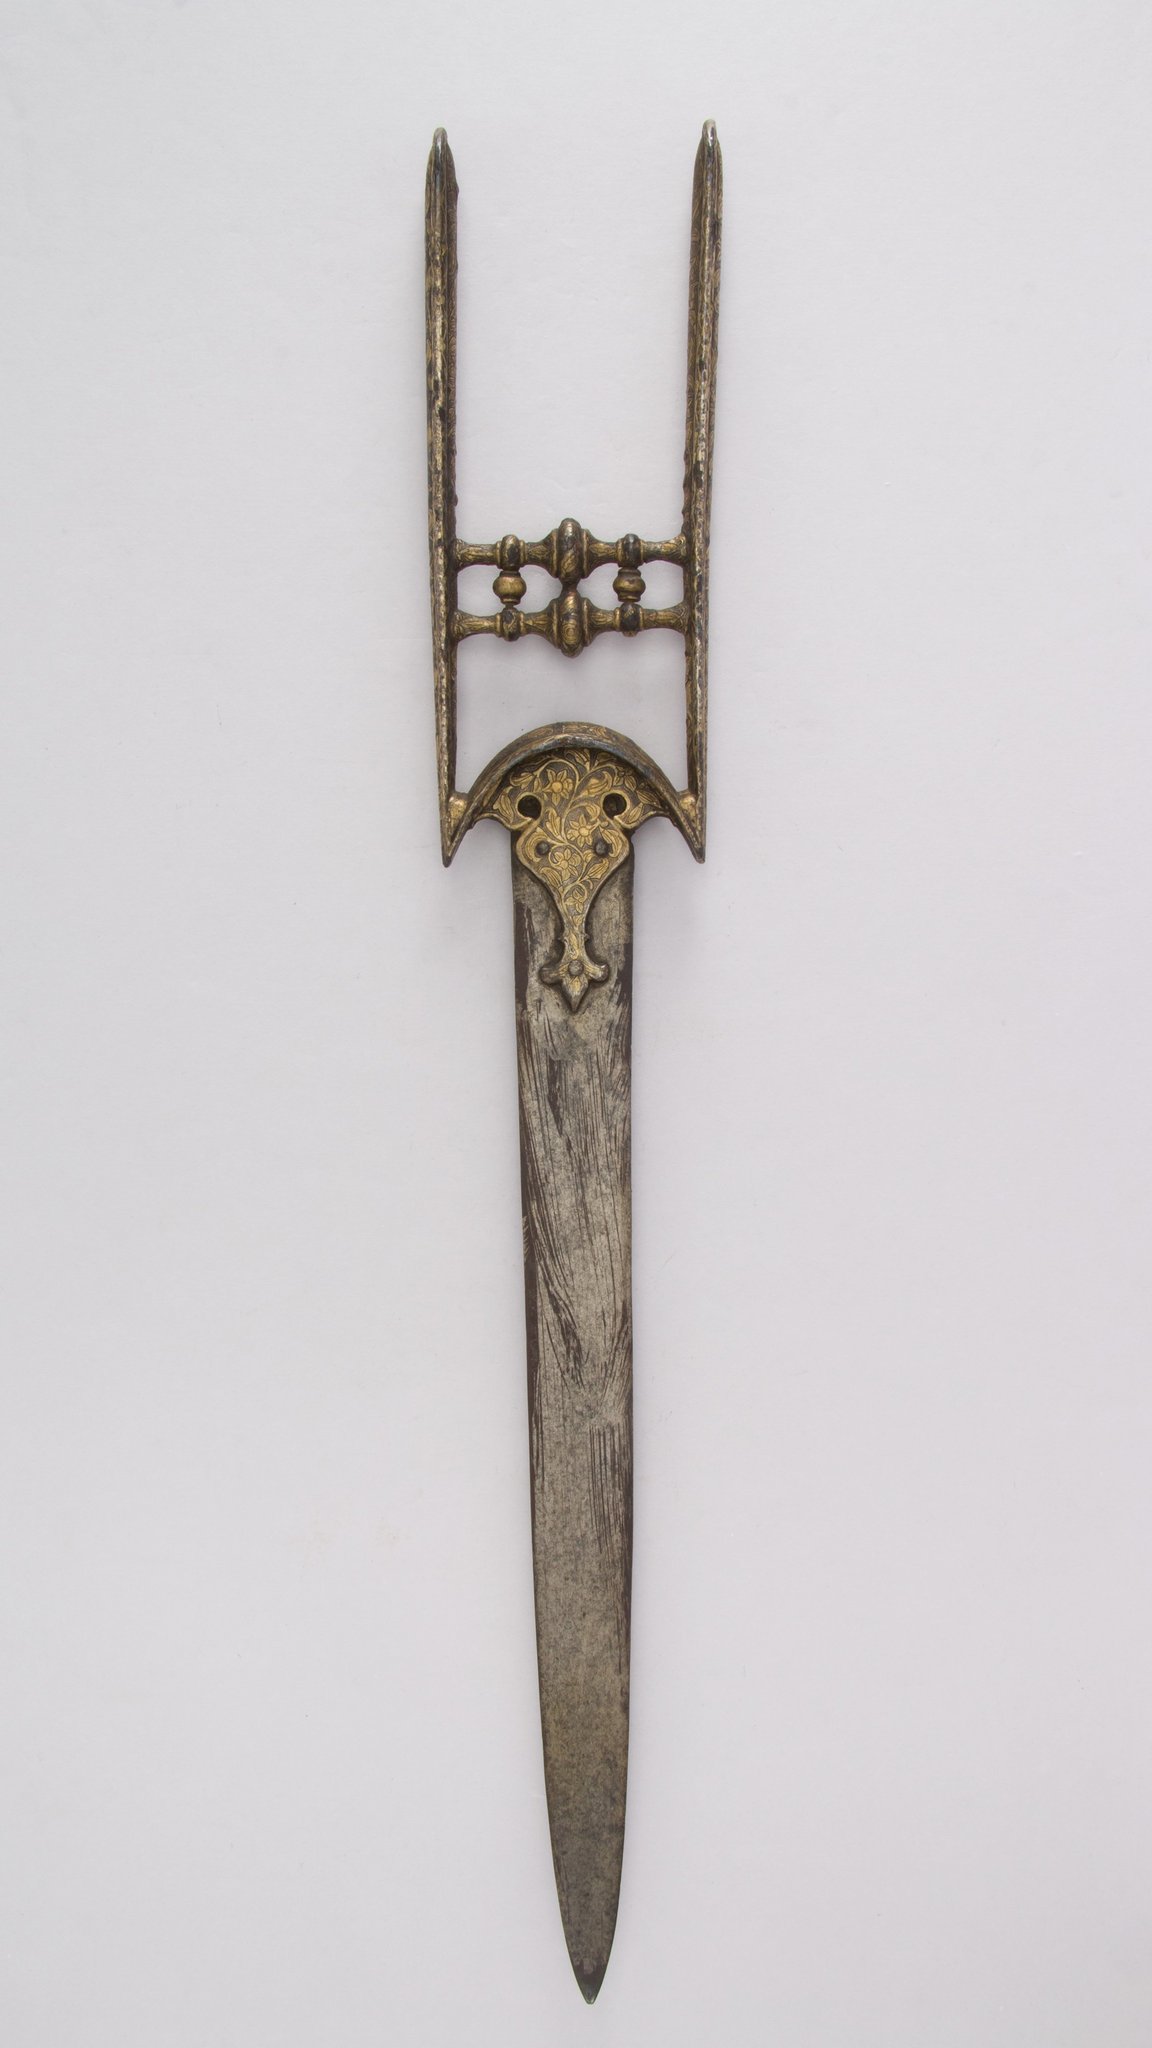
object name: dagger katar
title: Dagger (Katar)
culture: european or indian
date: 1767-1900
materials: gold, silver, steel